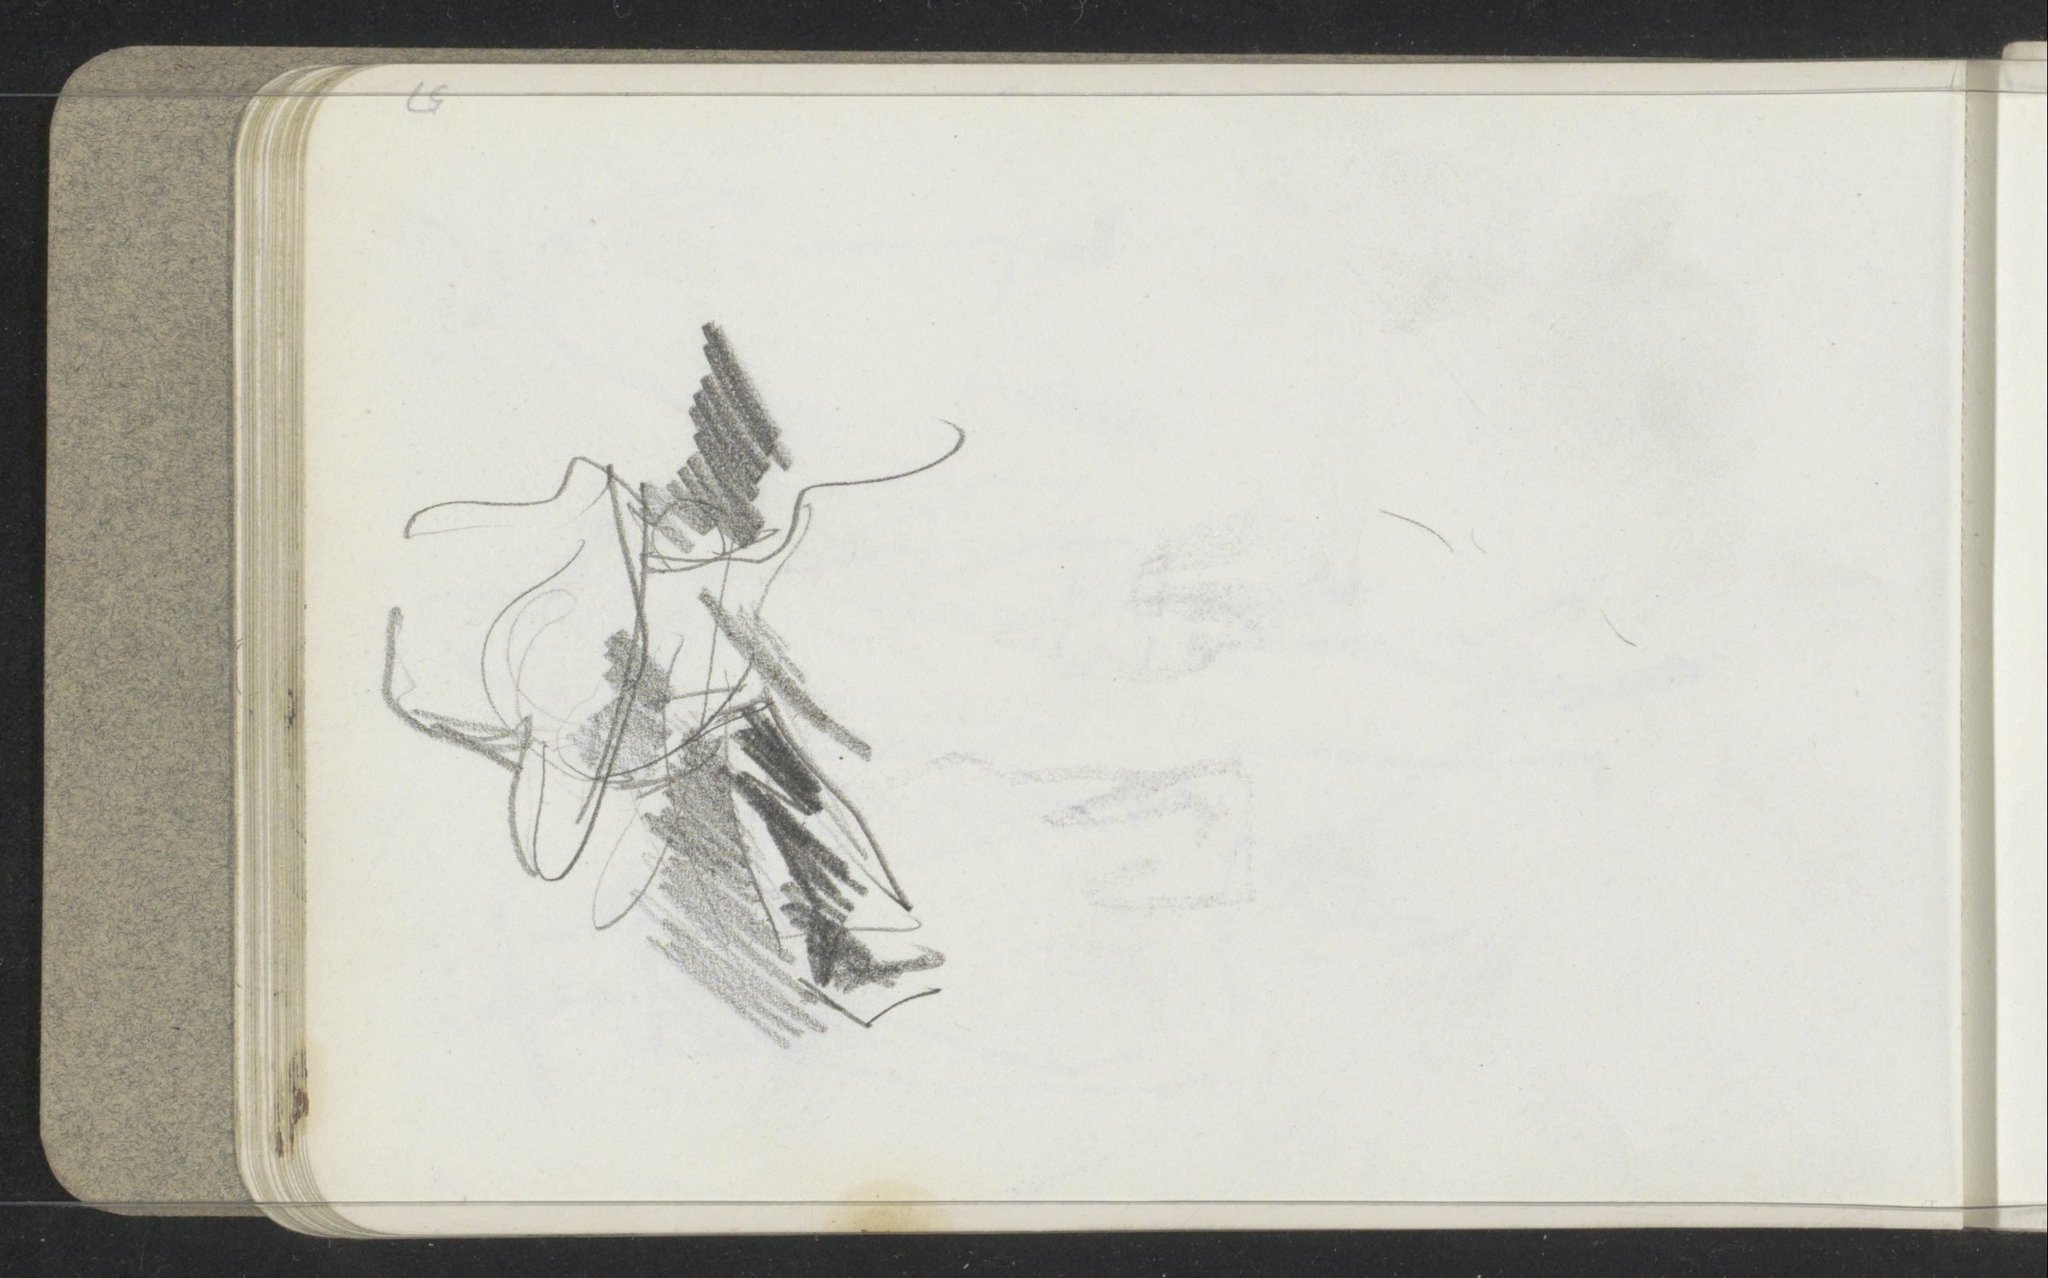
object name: sketchbook leaf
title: Vrouw met hoed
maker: isaac israels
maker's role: draughtsman, painter, print maker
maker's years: 1865-1934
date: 1875-1934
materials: paper, pencil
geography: the hague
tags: adult woman, head-gear: hat (+ women's clothes)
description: Blad 16 verso uit schetsboek LX met 33 bladen.